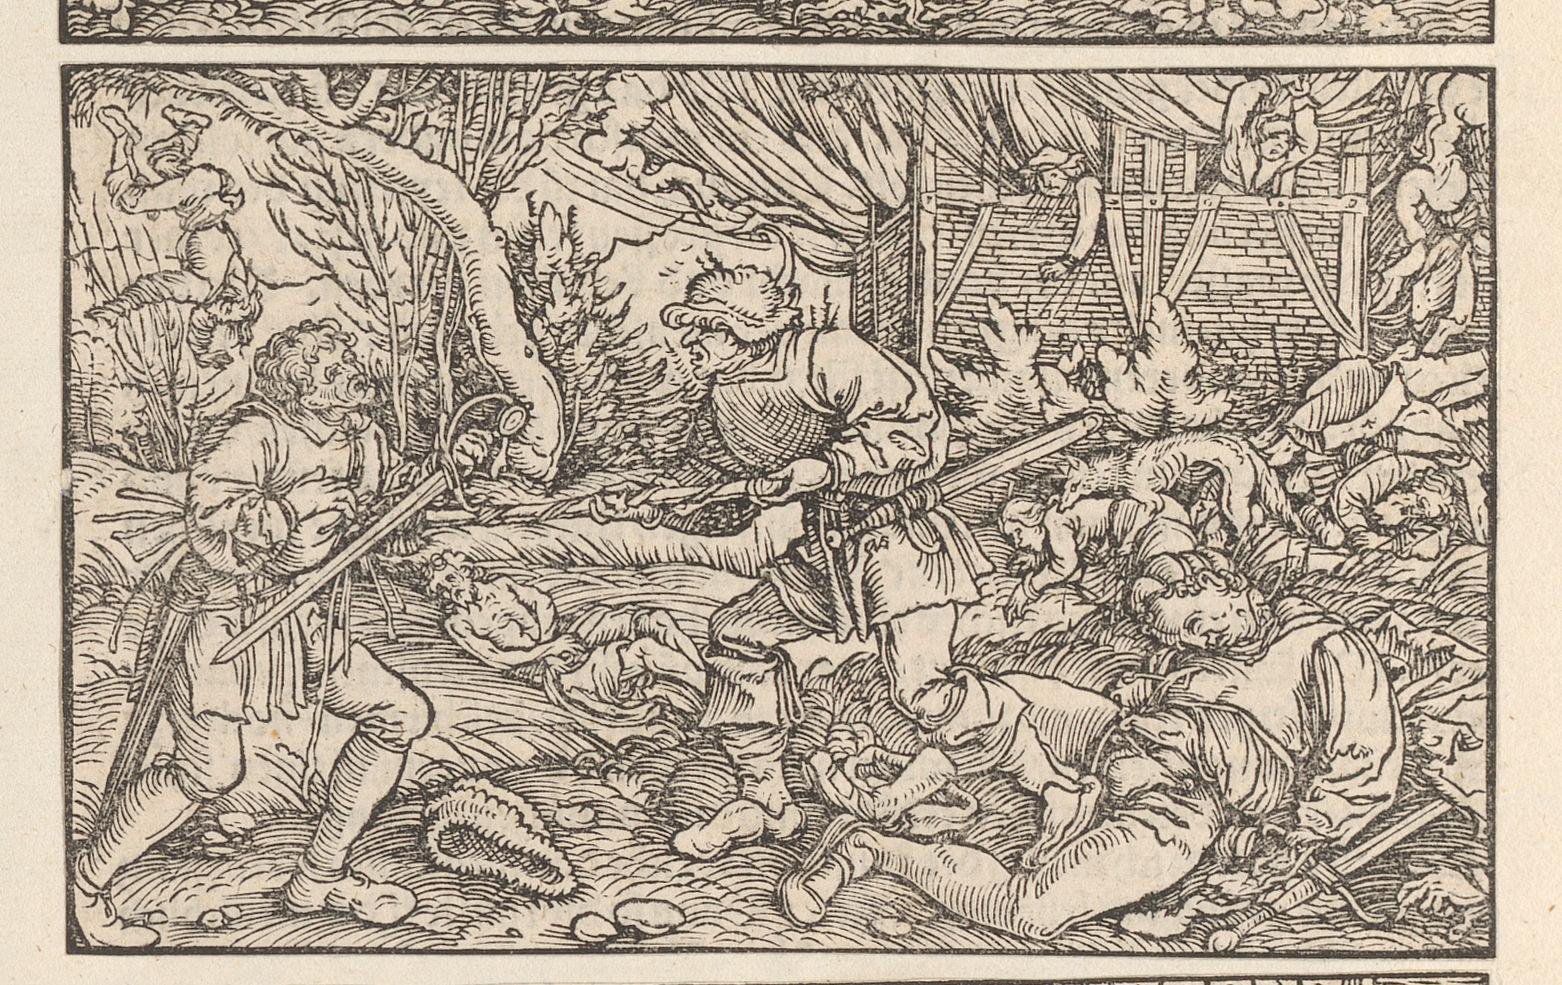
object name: book illustration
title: Manieren van een onnatuurlijke dood sterven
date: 1514-1531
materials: paper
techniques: letterpress printing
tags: death by accident (non-violent death), violent death by mutilation or maiming, murder, violent death ~ fire, dying, violent death by lance, spear, violent death by starvation, death struggle, inquiet death; fear of death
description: Deze prent is gebruikt in: Cicero, Marcus Tulius. Officia M.T.C. Ein Buch so Marcus Tullius Cicero der Römer zu seynem (...). [Vertaald uit het Latijn door] Johann von Schwarzenberg. Augsburg: Heinrich Steiner, 1531.